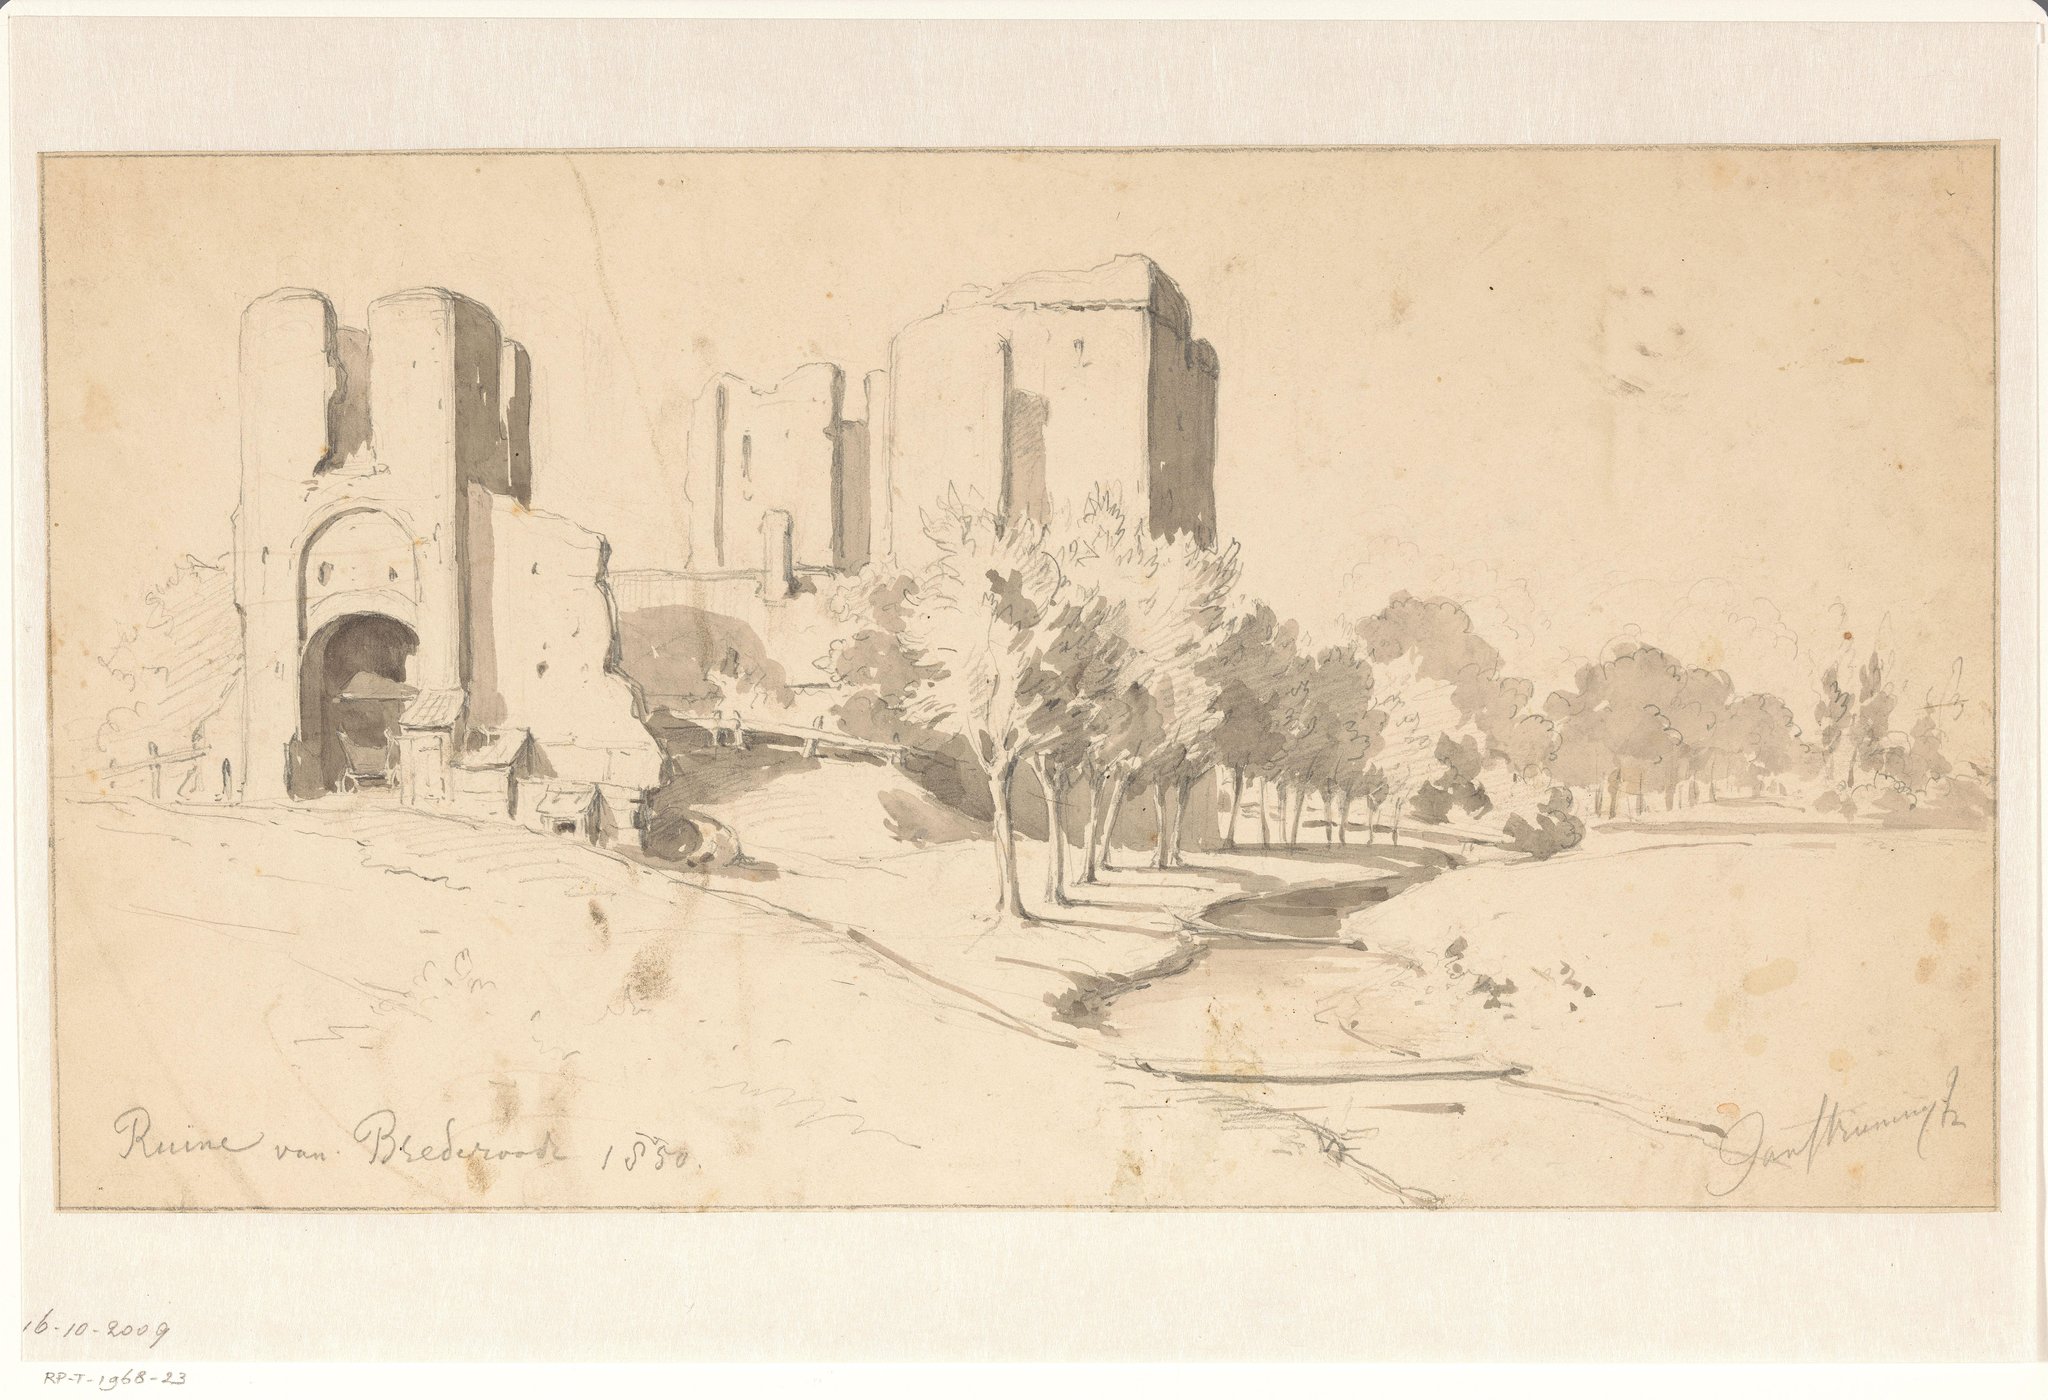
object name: drawing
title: Gezicht op de ruïne van Brederode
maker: jan striening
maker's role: draughtsman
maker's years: 1827-1903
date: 1850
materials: paper, pencil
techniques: brush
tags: ruin of a building ~ architecture